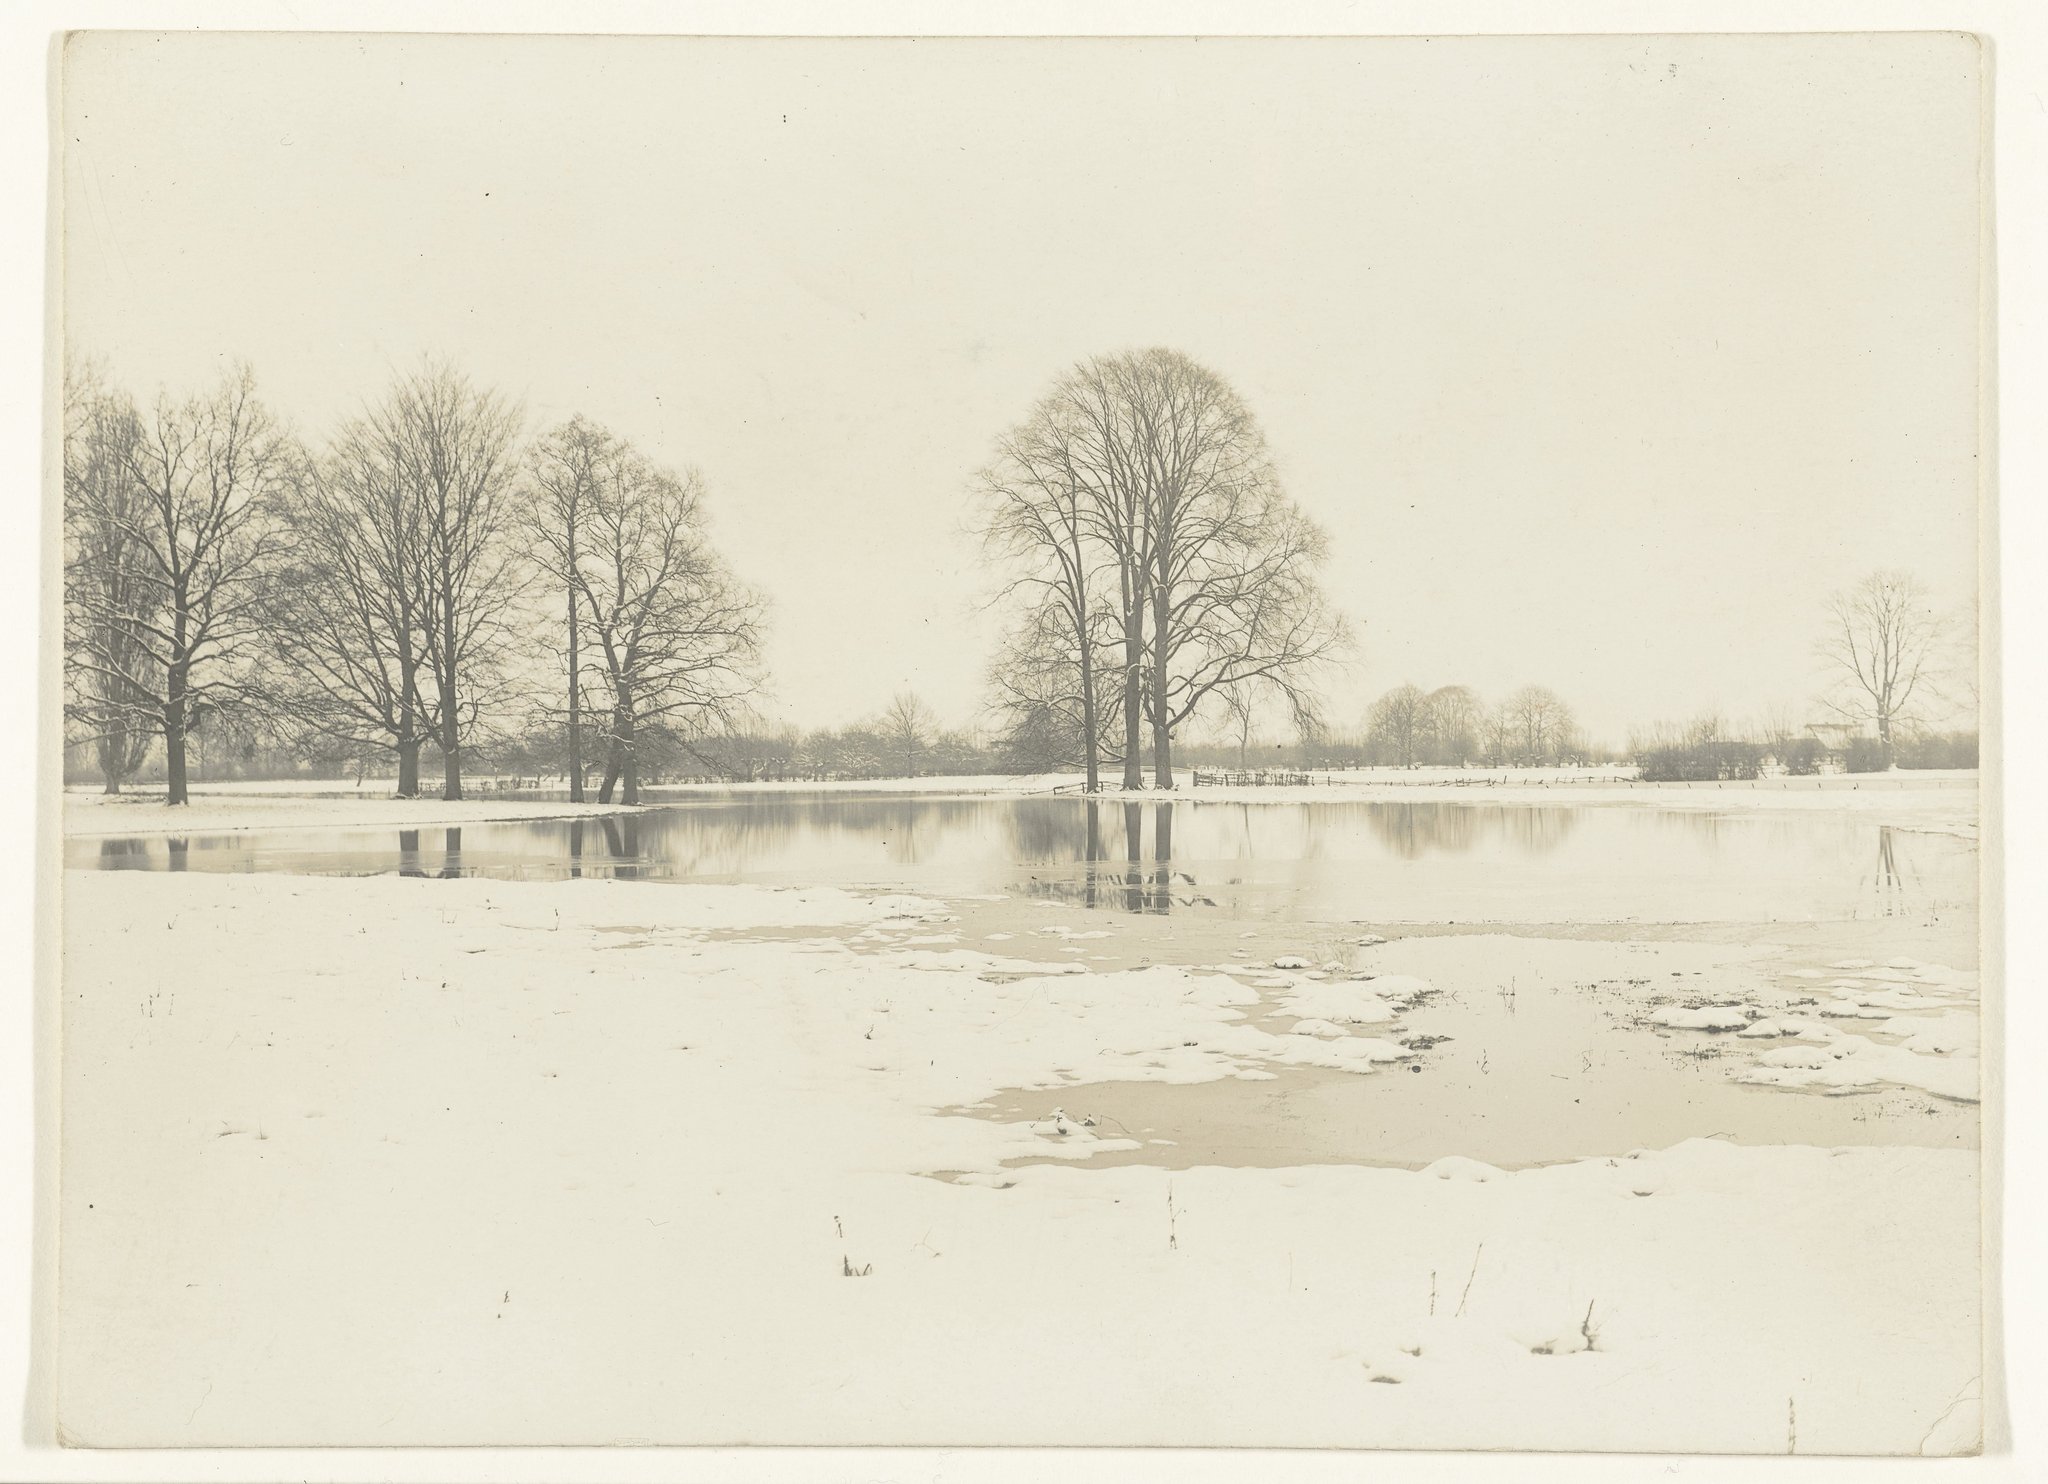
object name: photograph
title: Hoog water, sneeuw en ijs op het landgoed 'de Poll' in te Voorst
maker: richard tepe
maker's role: fotograaf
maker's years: 1864-1952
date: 1900-1930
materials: paper, photographic support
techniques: gelatin silver print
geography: netherlands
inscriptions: annotation: ‘Hoog Water sneeuw en ys / op het Landgoed 'De Poll' / te Voorst (G) / Ueberschwemmtes Gelände / mit Schnee und Eis / auf dem Landgute De Poll / in Voorst (Holland’, signature: ‘foto / R. Tepe’